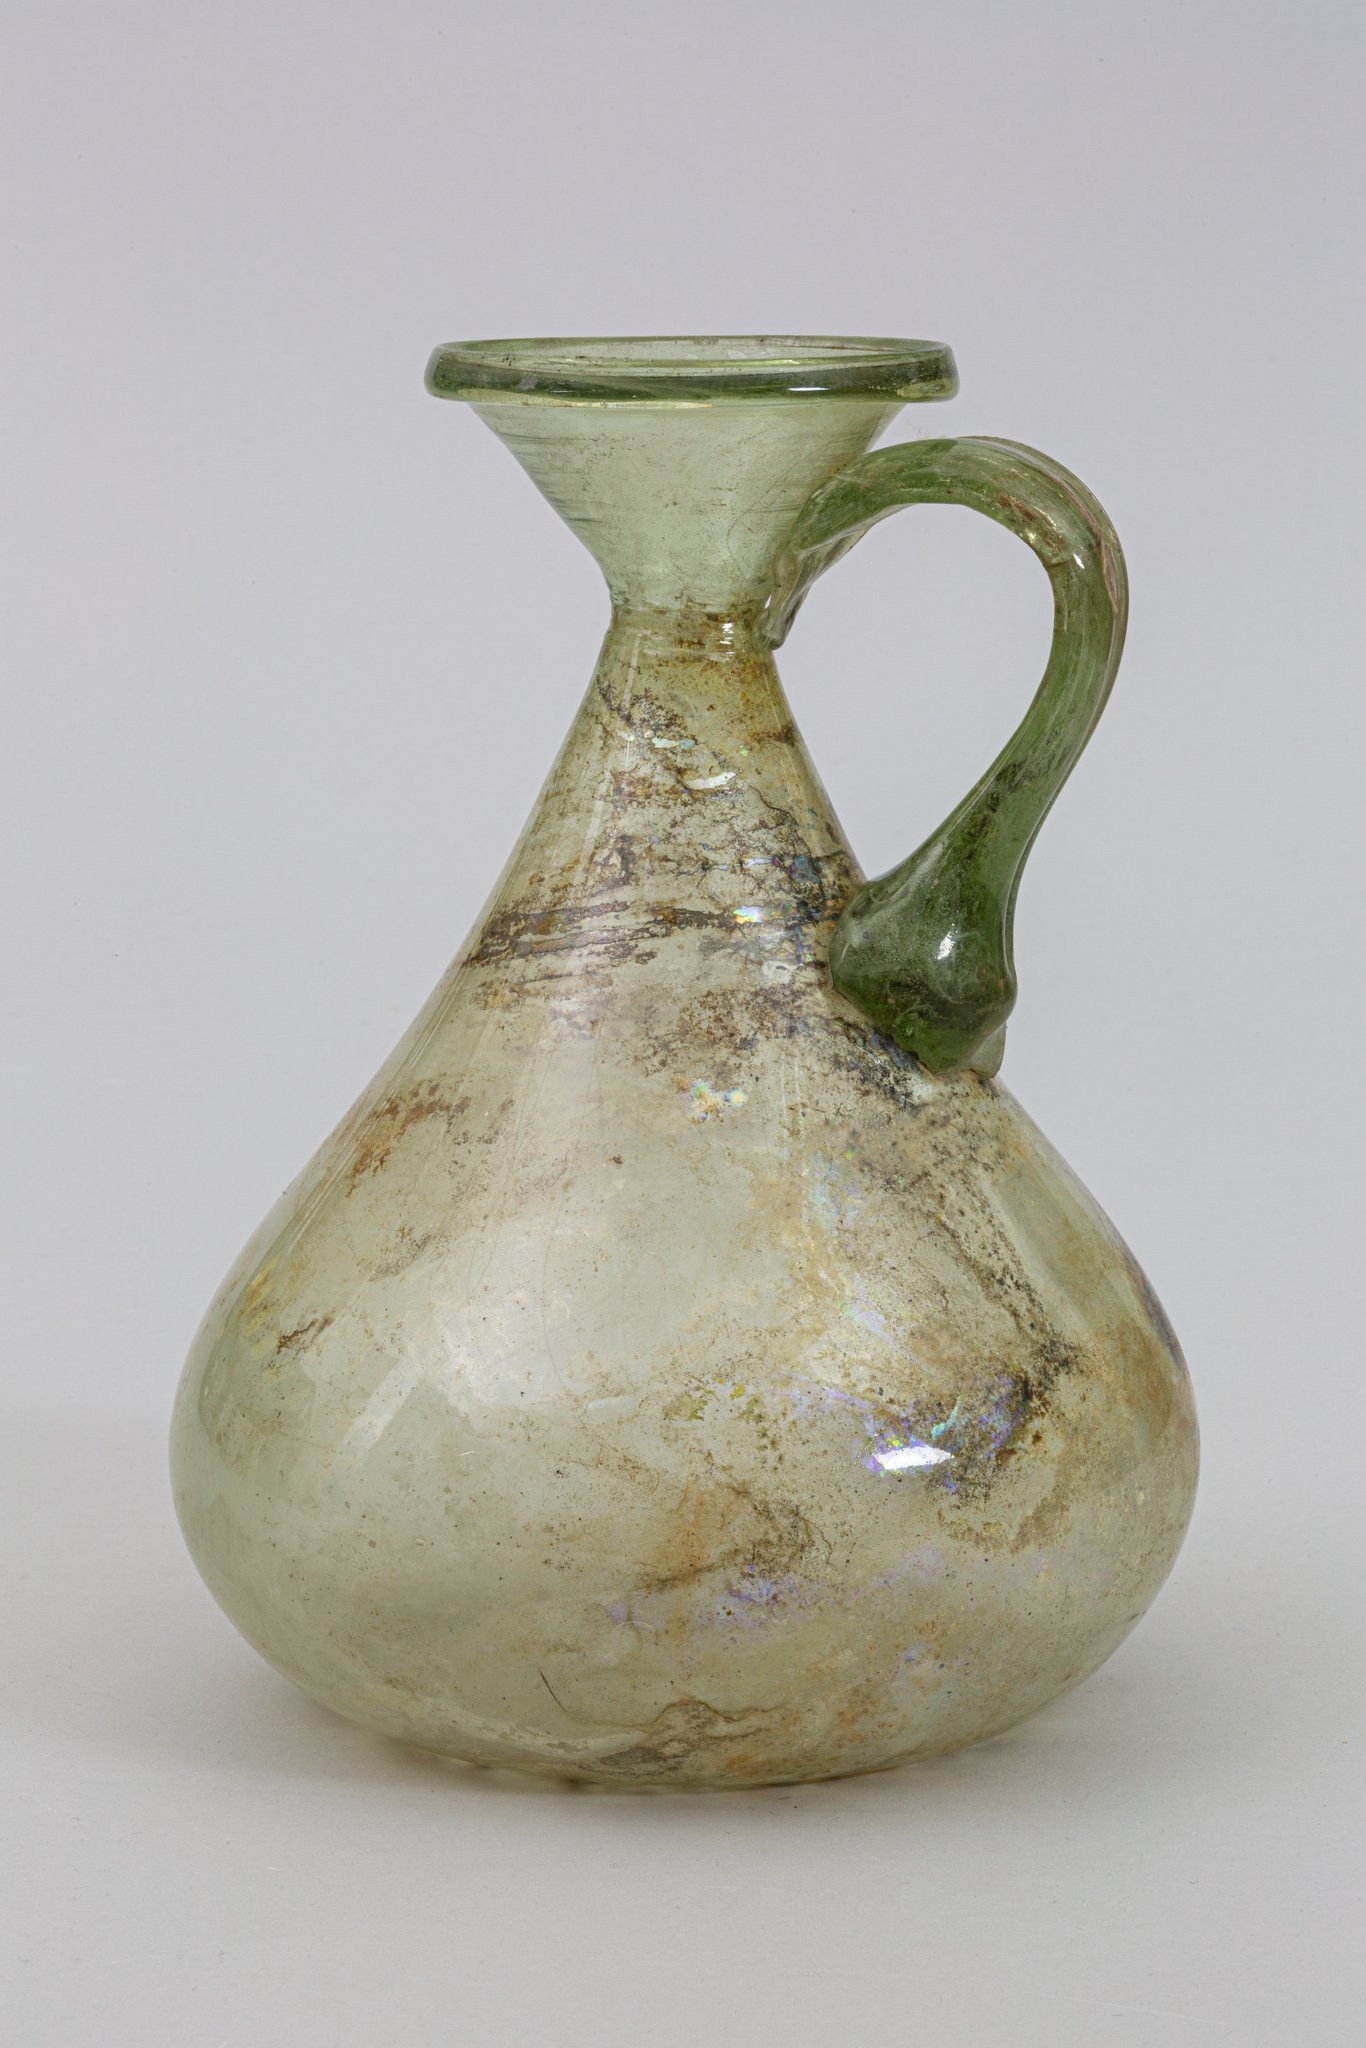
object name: jug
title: Glass jug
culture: roman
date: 201-400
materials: glass